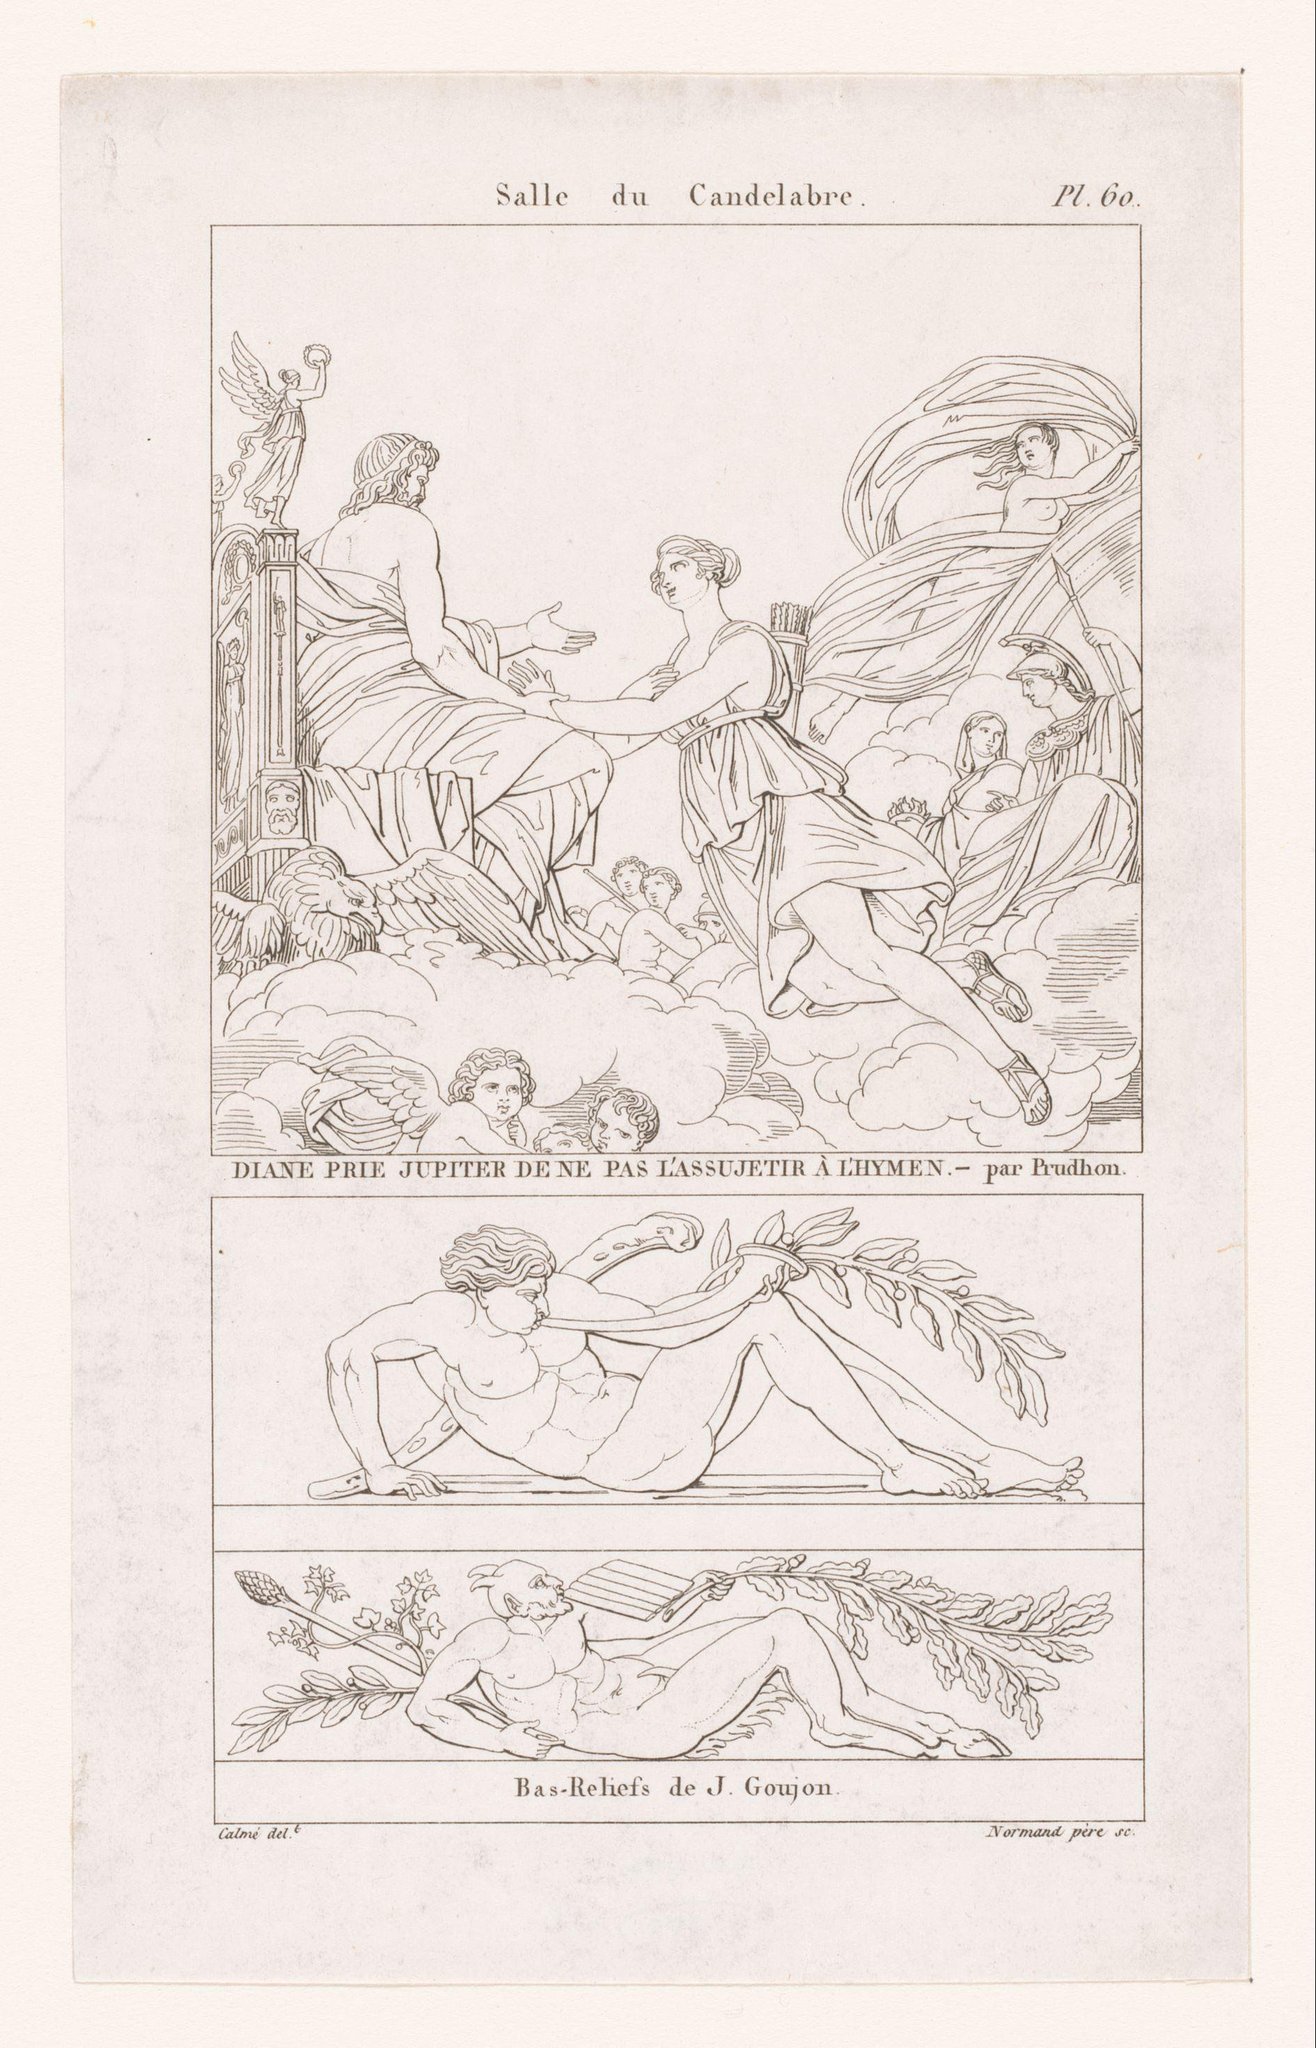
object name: print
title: Diana vraagt Jupiter om eeuwige maagdelijkheid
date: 1803-1840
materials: paper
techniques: etching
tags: diana asks jupiter to give her eternal virginity, satyr(s) (in general)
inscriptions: collector's mark: Lugt 2760, collector's mark: Lugt 2228